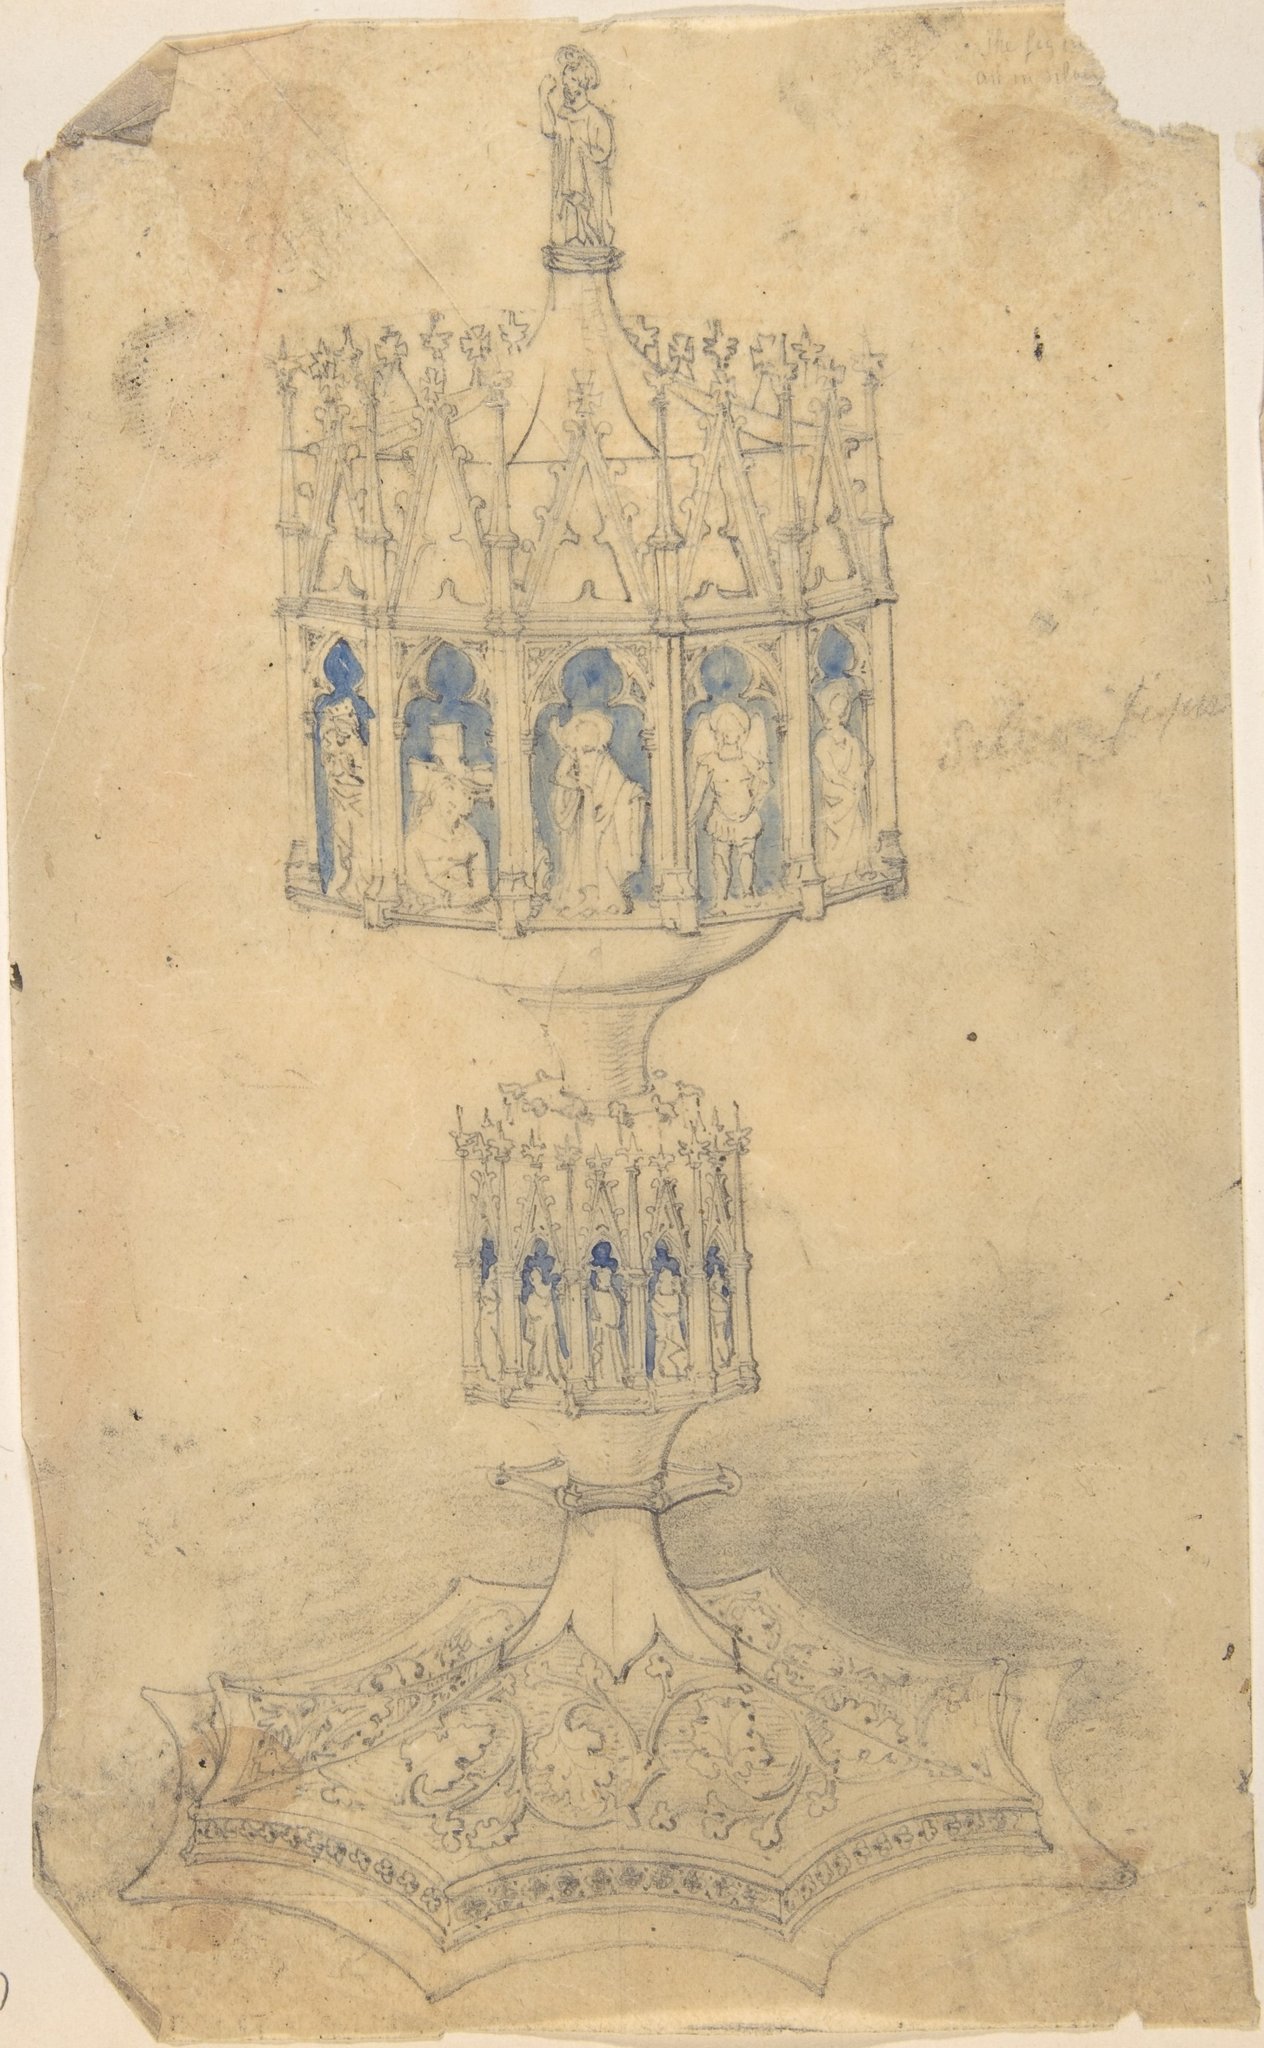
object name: drawing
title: Liturgical Incense Burner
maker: anonymous, british, 19th century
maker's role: artist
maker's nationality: british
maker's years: 1800-1900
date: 1851-1900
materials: graphite, watercolor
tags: incense burners